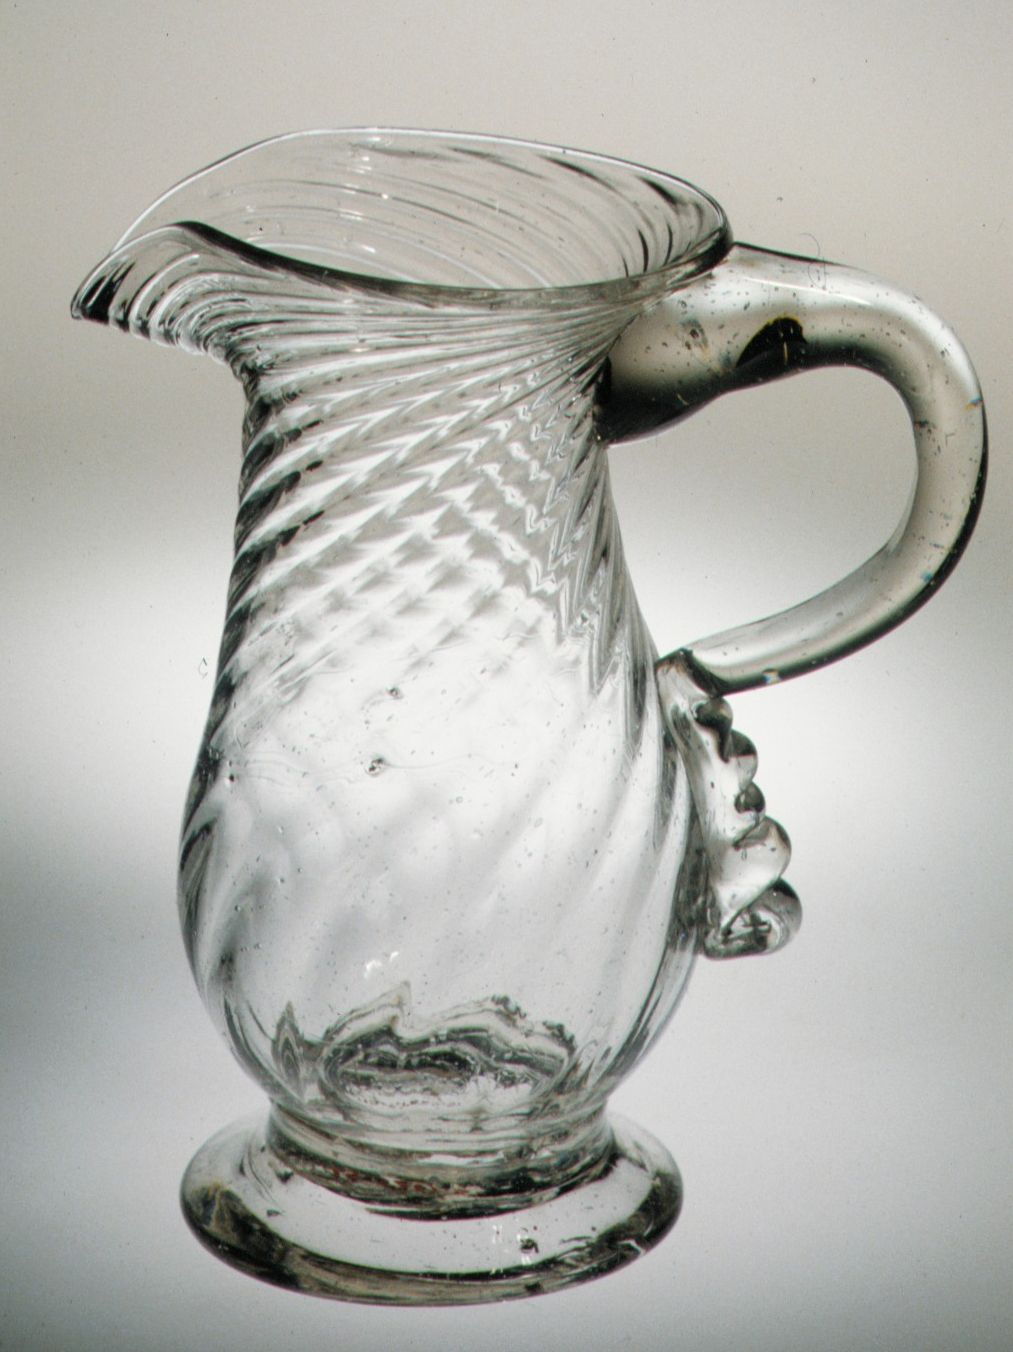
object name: cream pot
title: Creamer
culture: american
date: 1780-1825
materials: glass, lead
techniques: glassblowing, molding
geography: united states